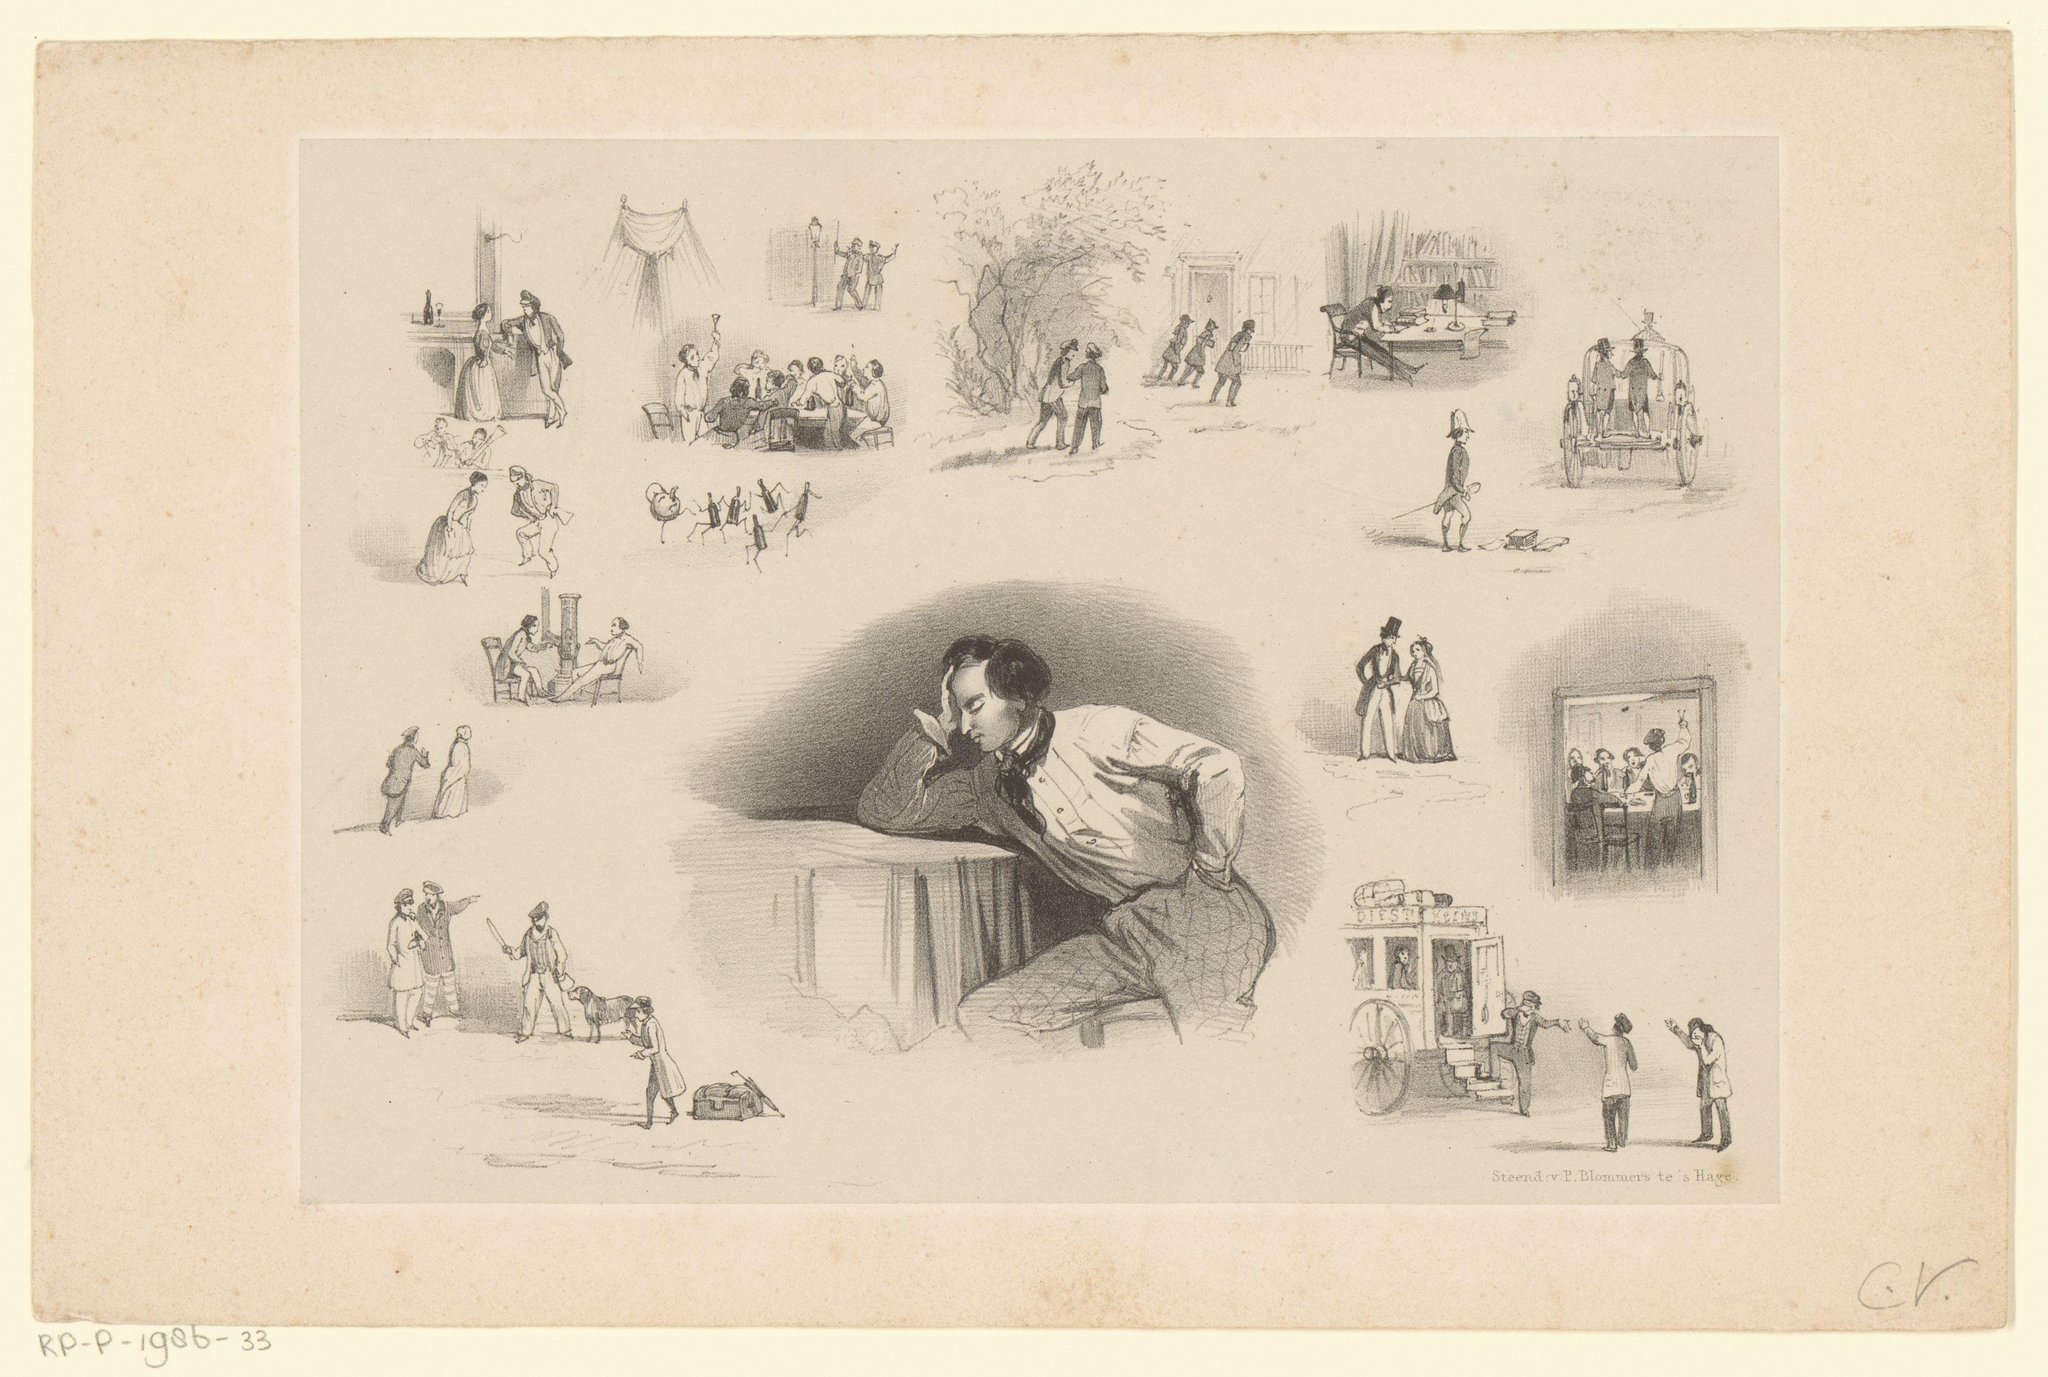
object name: print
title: Verschillende taferelen uit het studentenleven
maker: p. blommers (steendrukkerij van)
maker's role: printer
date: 1842-1887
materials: paper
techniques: lithograph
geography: the hague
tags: student life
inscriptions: collector's mark: Lugt 2760, collector's mark: Lugt 2228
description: Een student is diep in gedachten verzonken. Rondom taferelen uit zijn studentenleven.